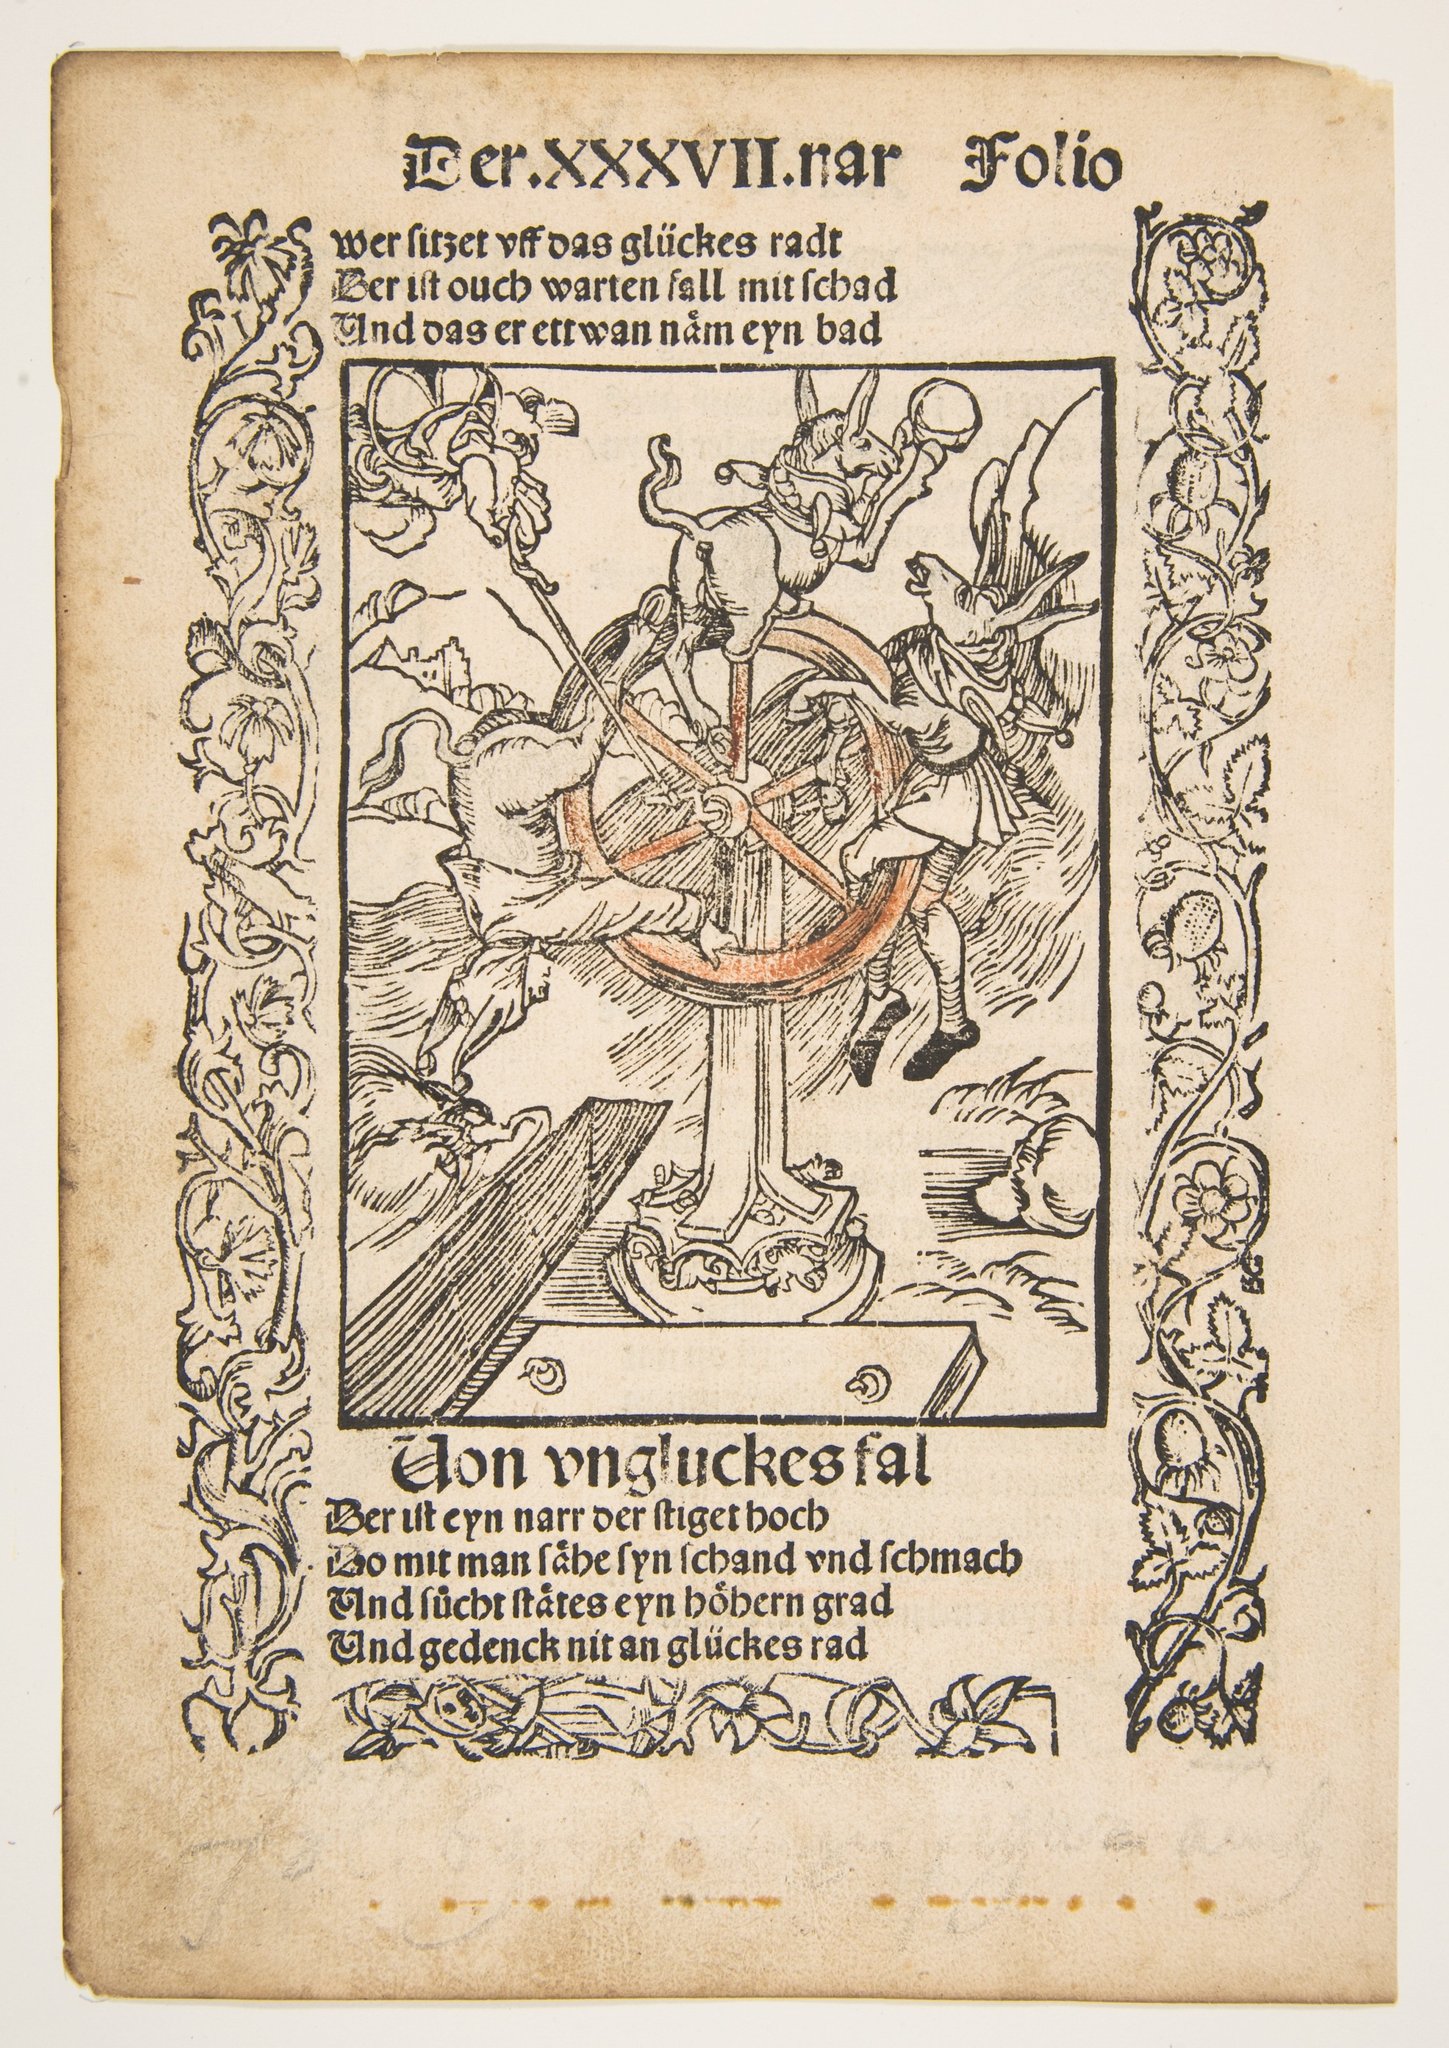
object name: print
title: Von Ungluckes Fal, title page chapter 37 from "Sebastian Brandt, Das Narrenschrift"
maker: albrecht dürer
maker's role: artist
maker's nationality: german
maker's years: 1471-1528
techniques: woodcut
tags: horses